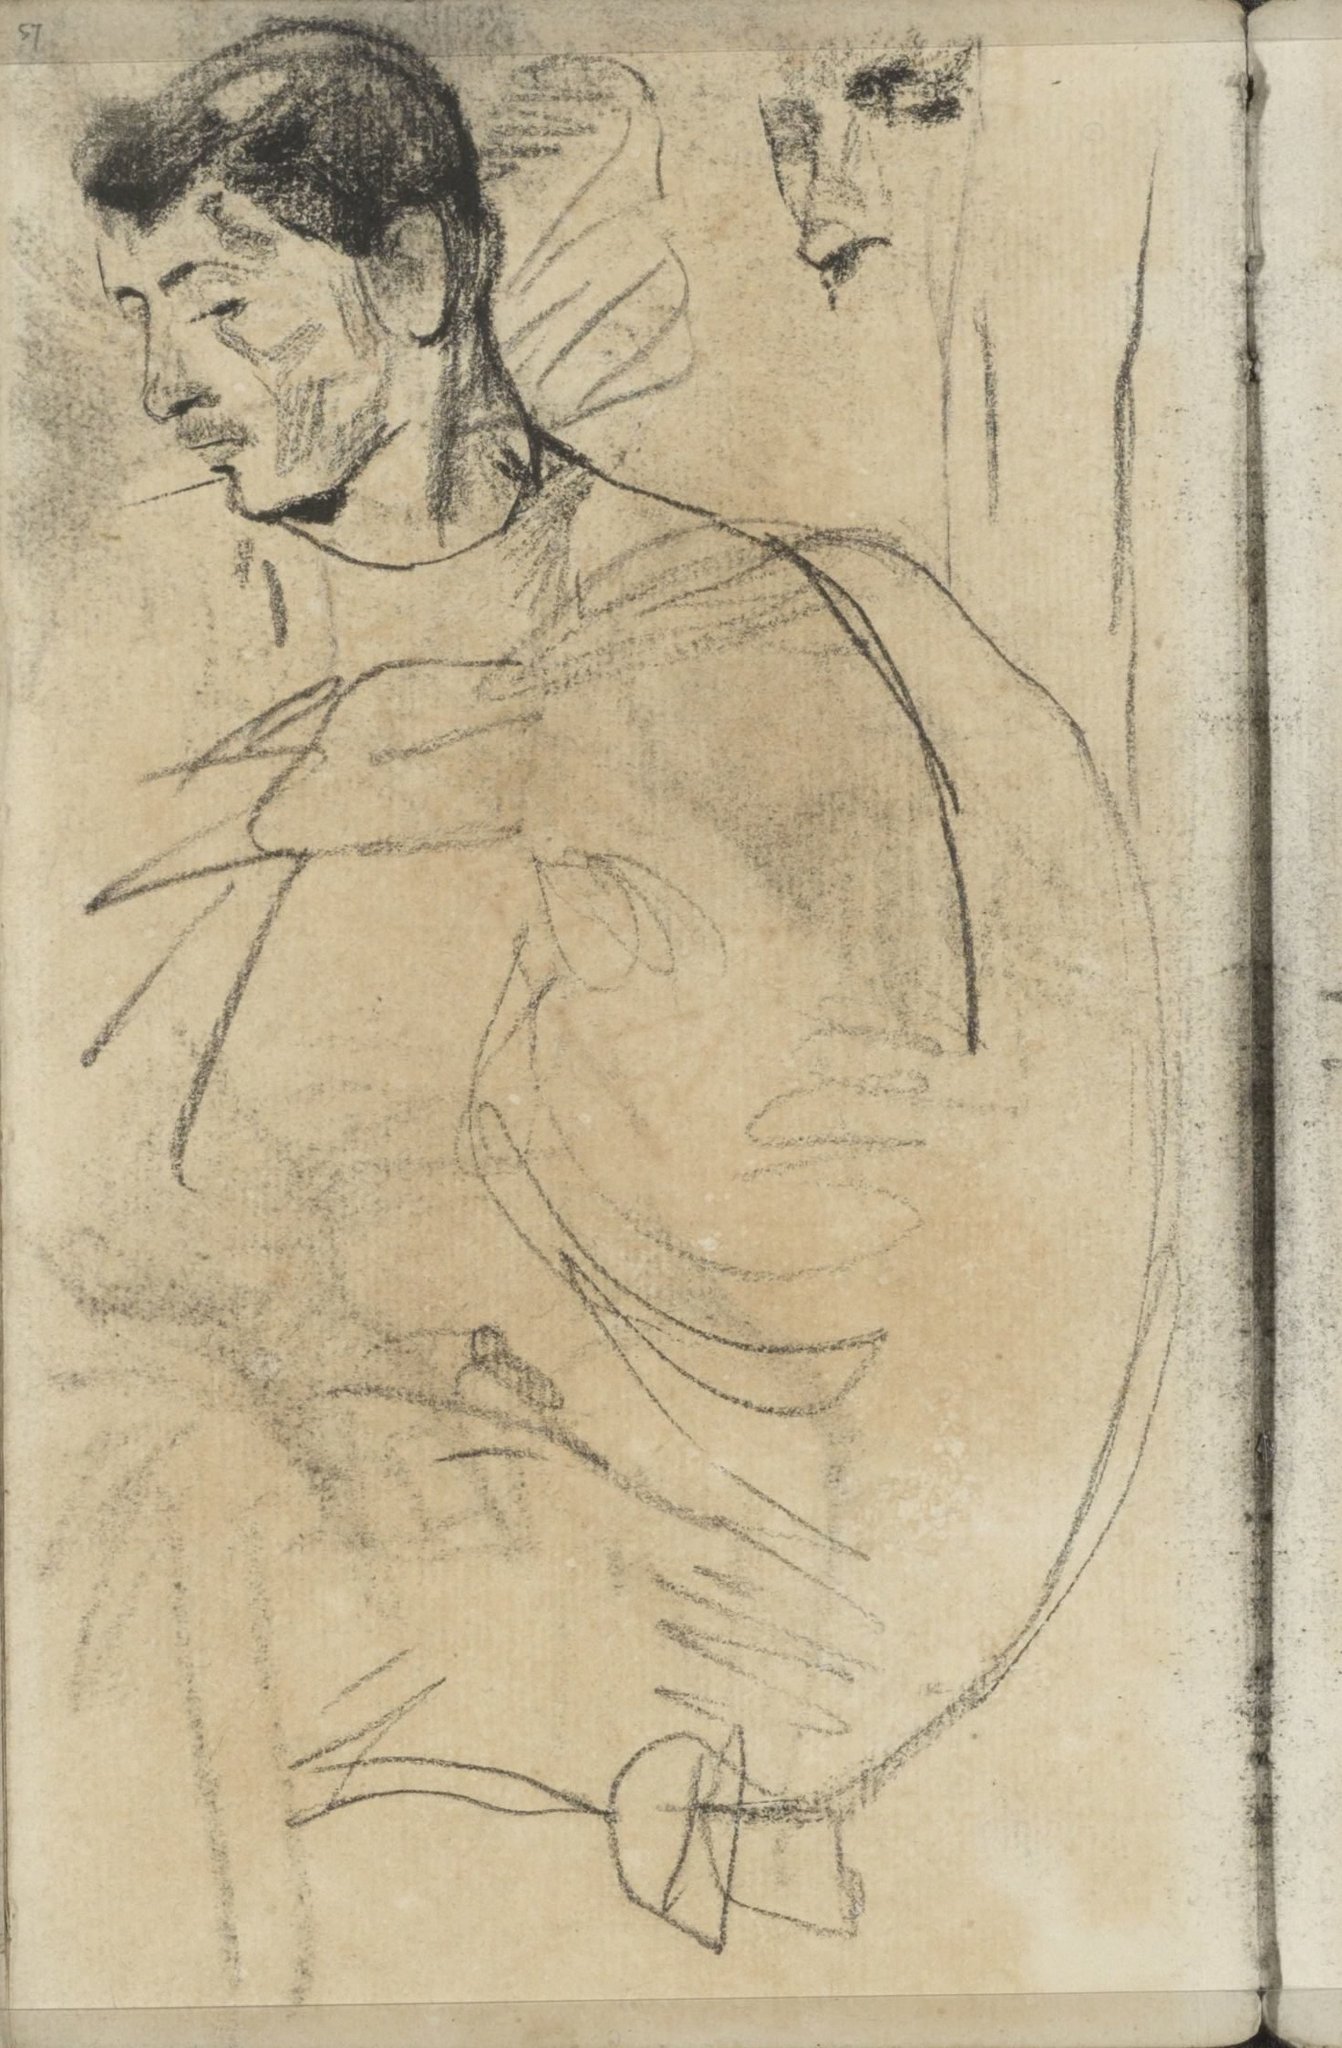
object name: sketchbook leaf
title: Twee studies van een man, mogelijk museumdirecteur Adriaan Pit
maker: george hendrik breitner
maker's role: draughtsman, painter, print maker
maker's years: 1857-1923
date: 1884-1886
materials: chalk, paper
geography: the hague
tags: nijmegen, adriaan pit, adult man, anonymous historical person portrayed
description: Pagina 57 uit een schetsboek met 29 bladen.